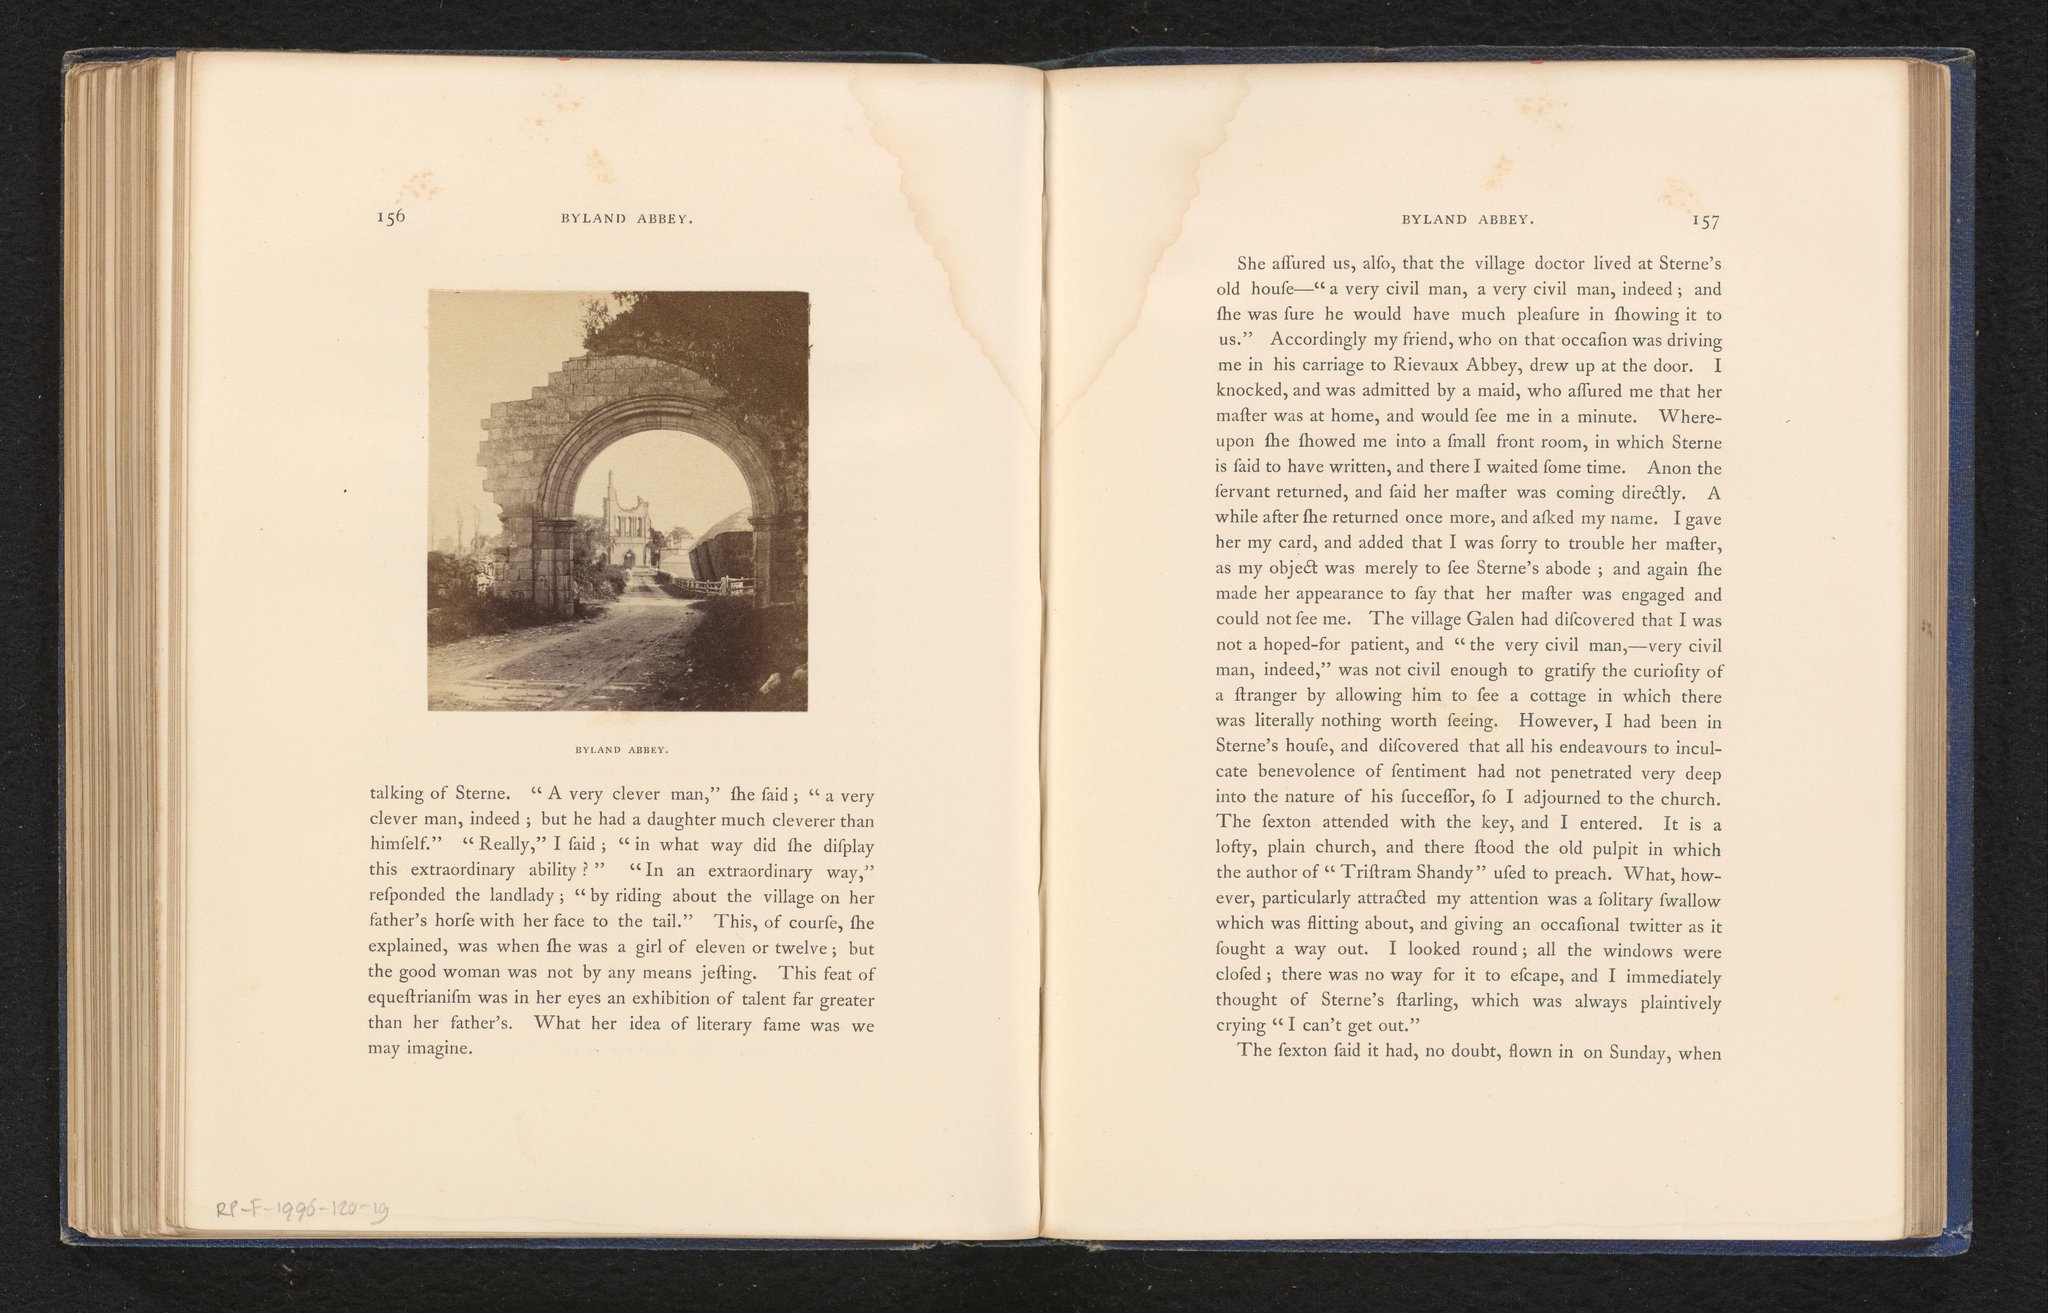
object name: photograph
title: Gezicht op Byland Abbey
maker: thomas ogle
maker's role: fotograaf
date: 1859-1864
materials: paper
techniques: albumen print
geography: byland abbey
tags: ruin of a dwelling, house, castle, etc.